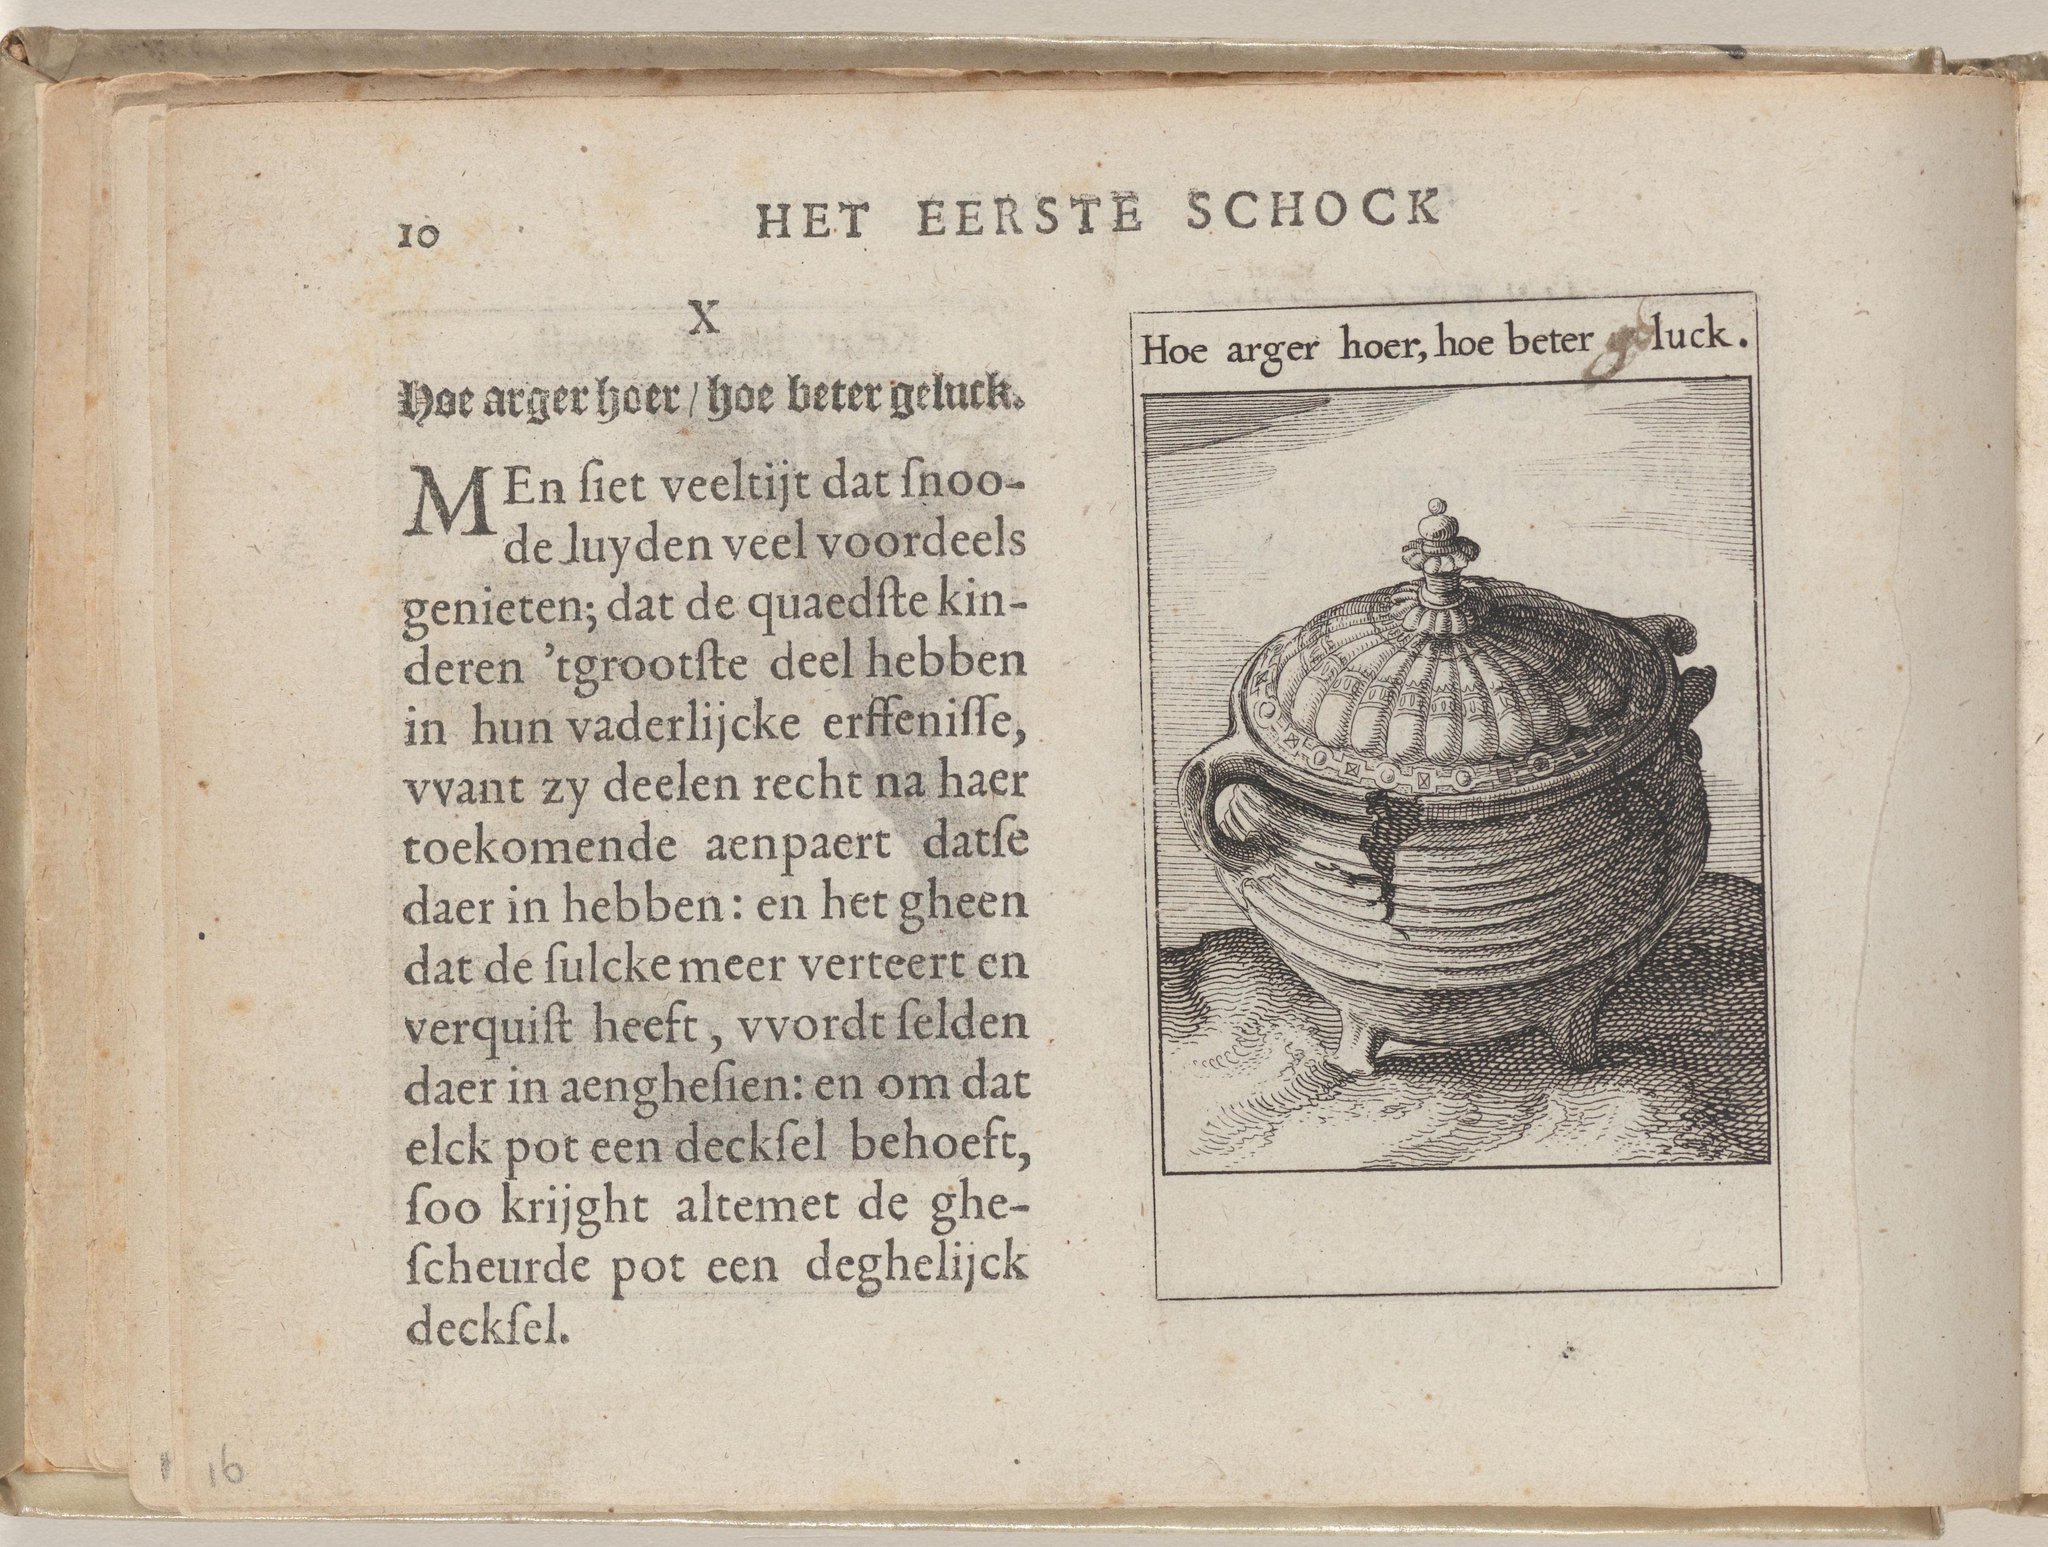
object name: print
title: X Hoe arger hoer, hoe beter geluck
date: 1614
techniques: engraving, printing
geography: amsterdam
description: X Hoe arger hoer, hoe beter geluck. Eerste schok. Onderdeel van 'Sinnepoppen', R. Visscher, 1614.